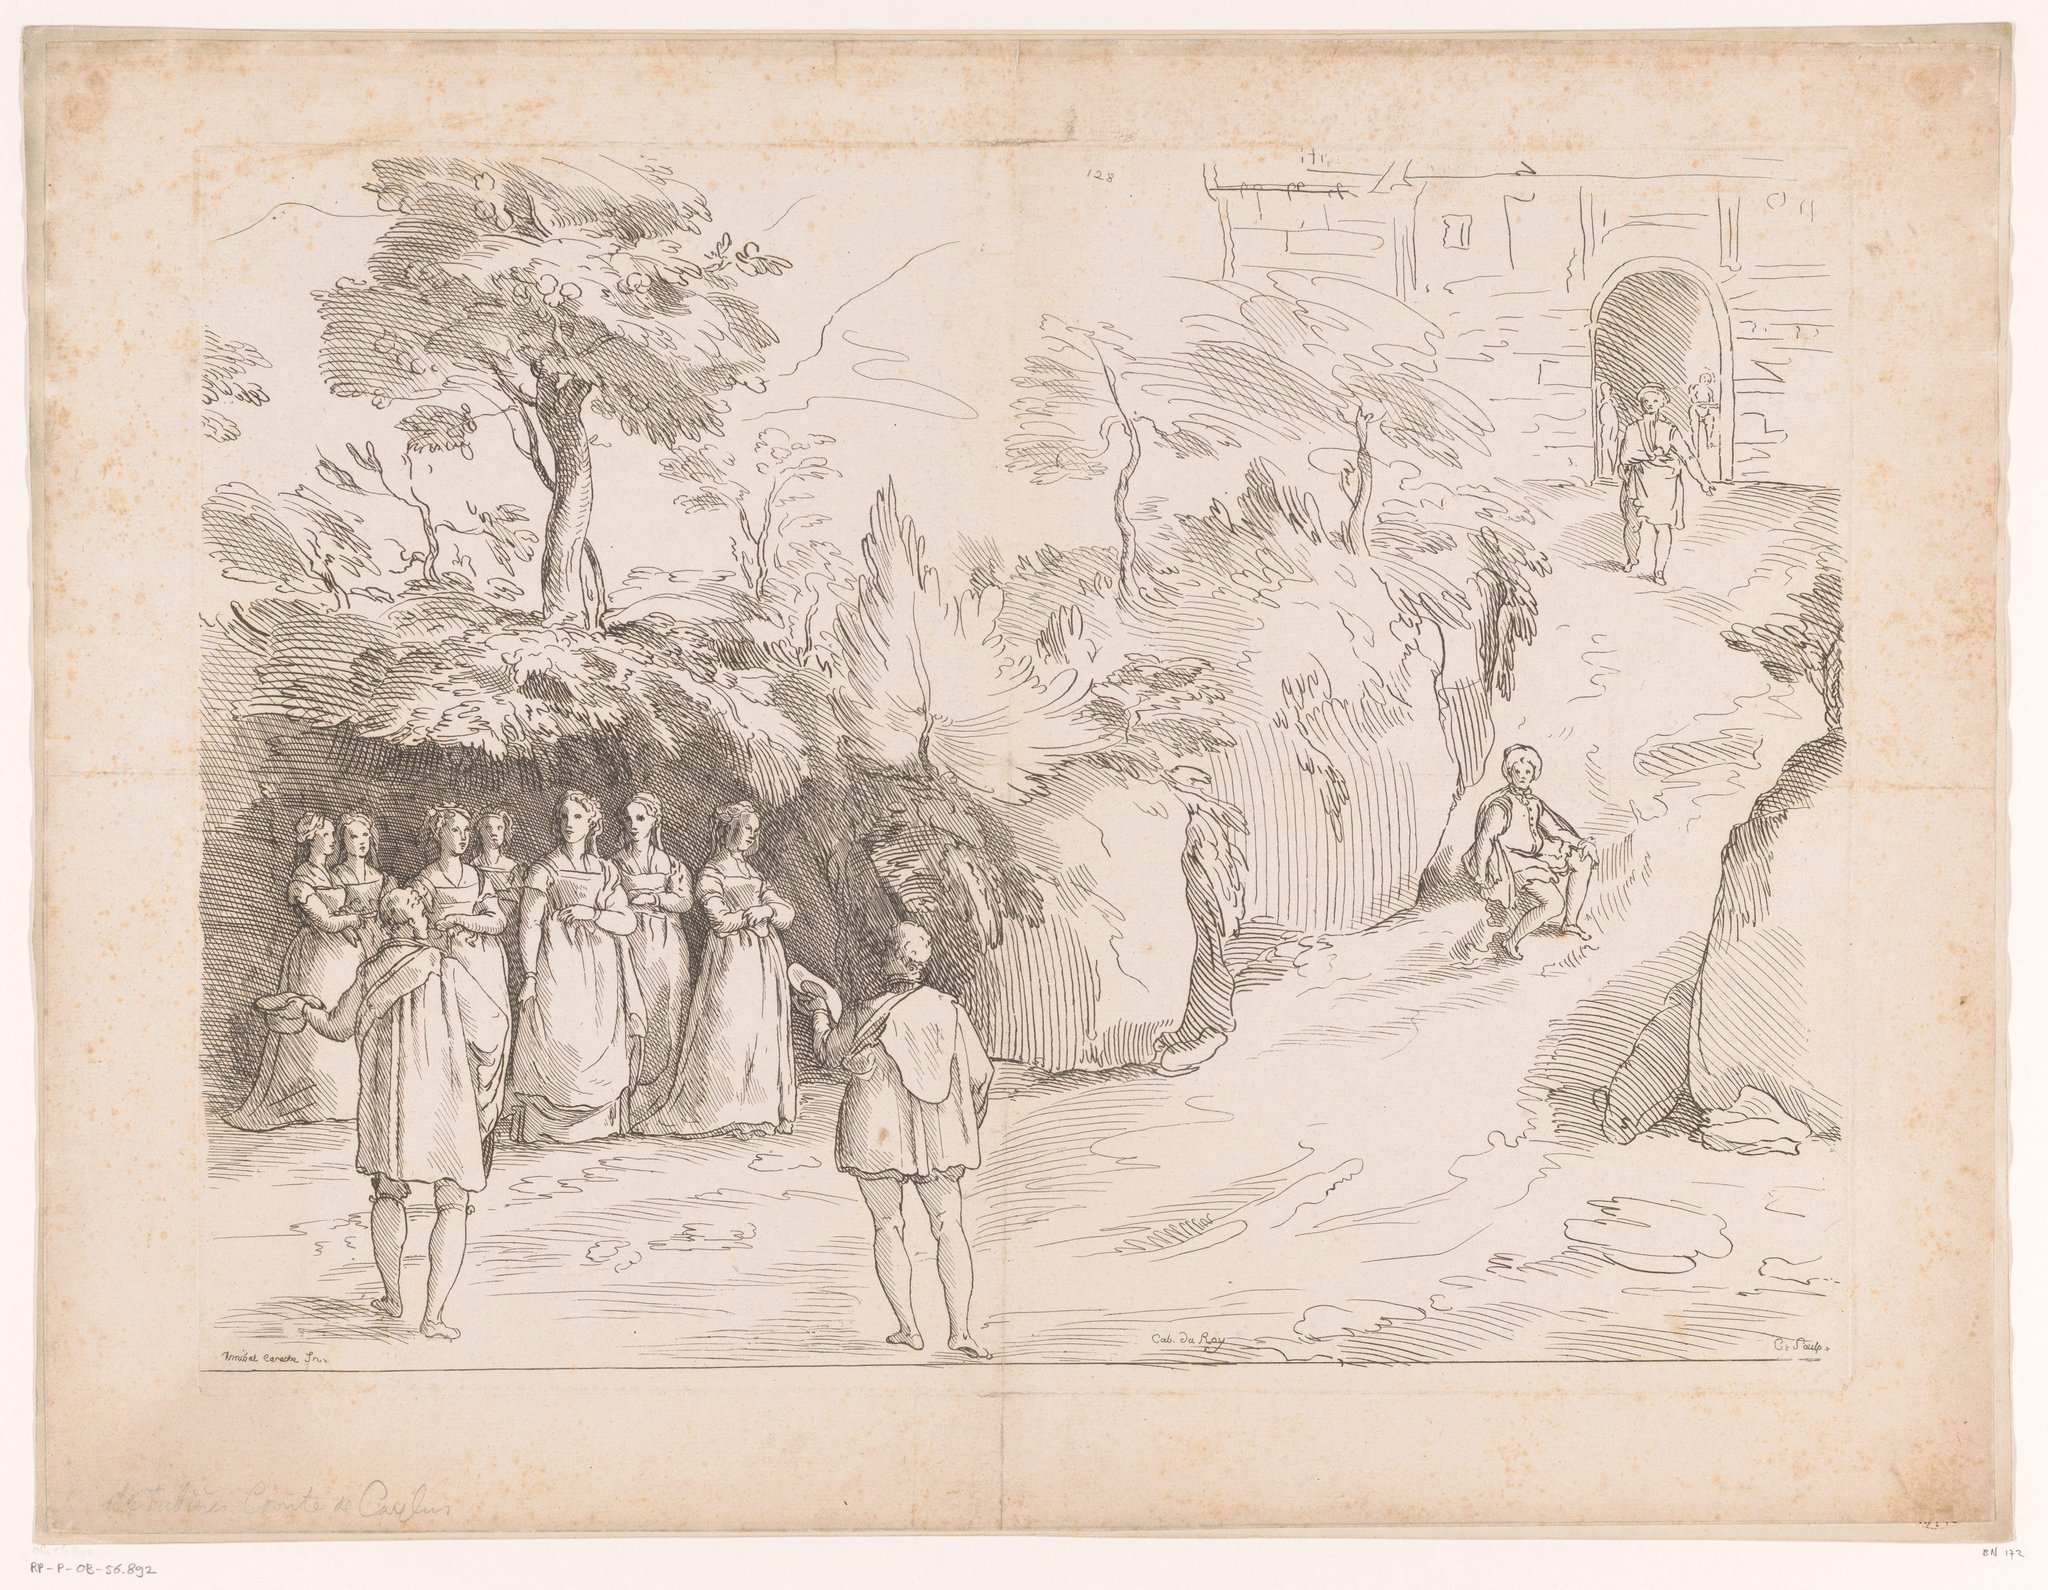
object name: print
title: Bruidsstoet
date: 1702-1765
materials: paper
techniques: etching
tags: (civil) marriage ceremonies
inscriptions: collector's mark: Lugt 240